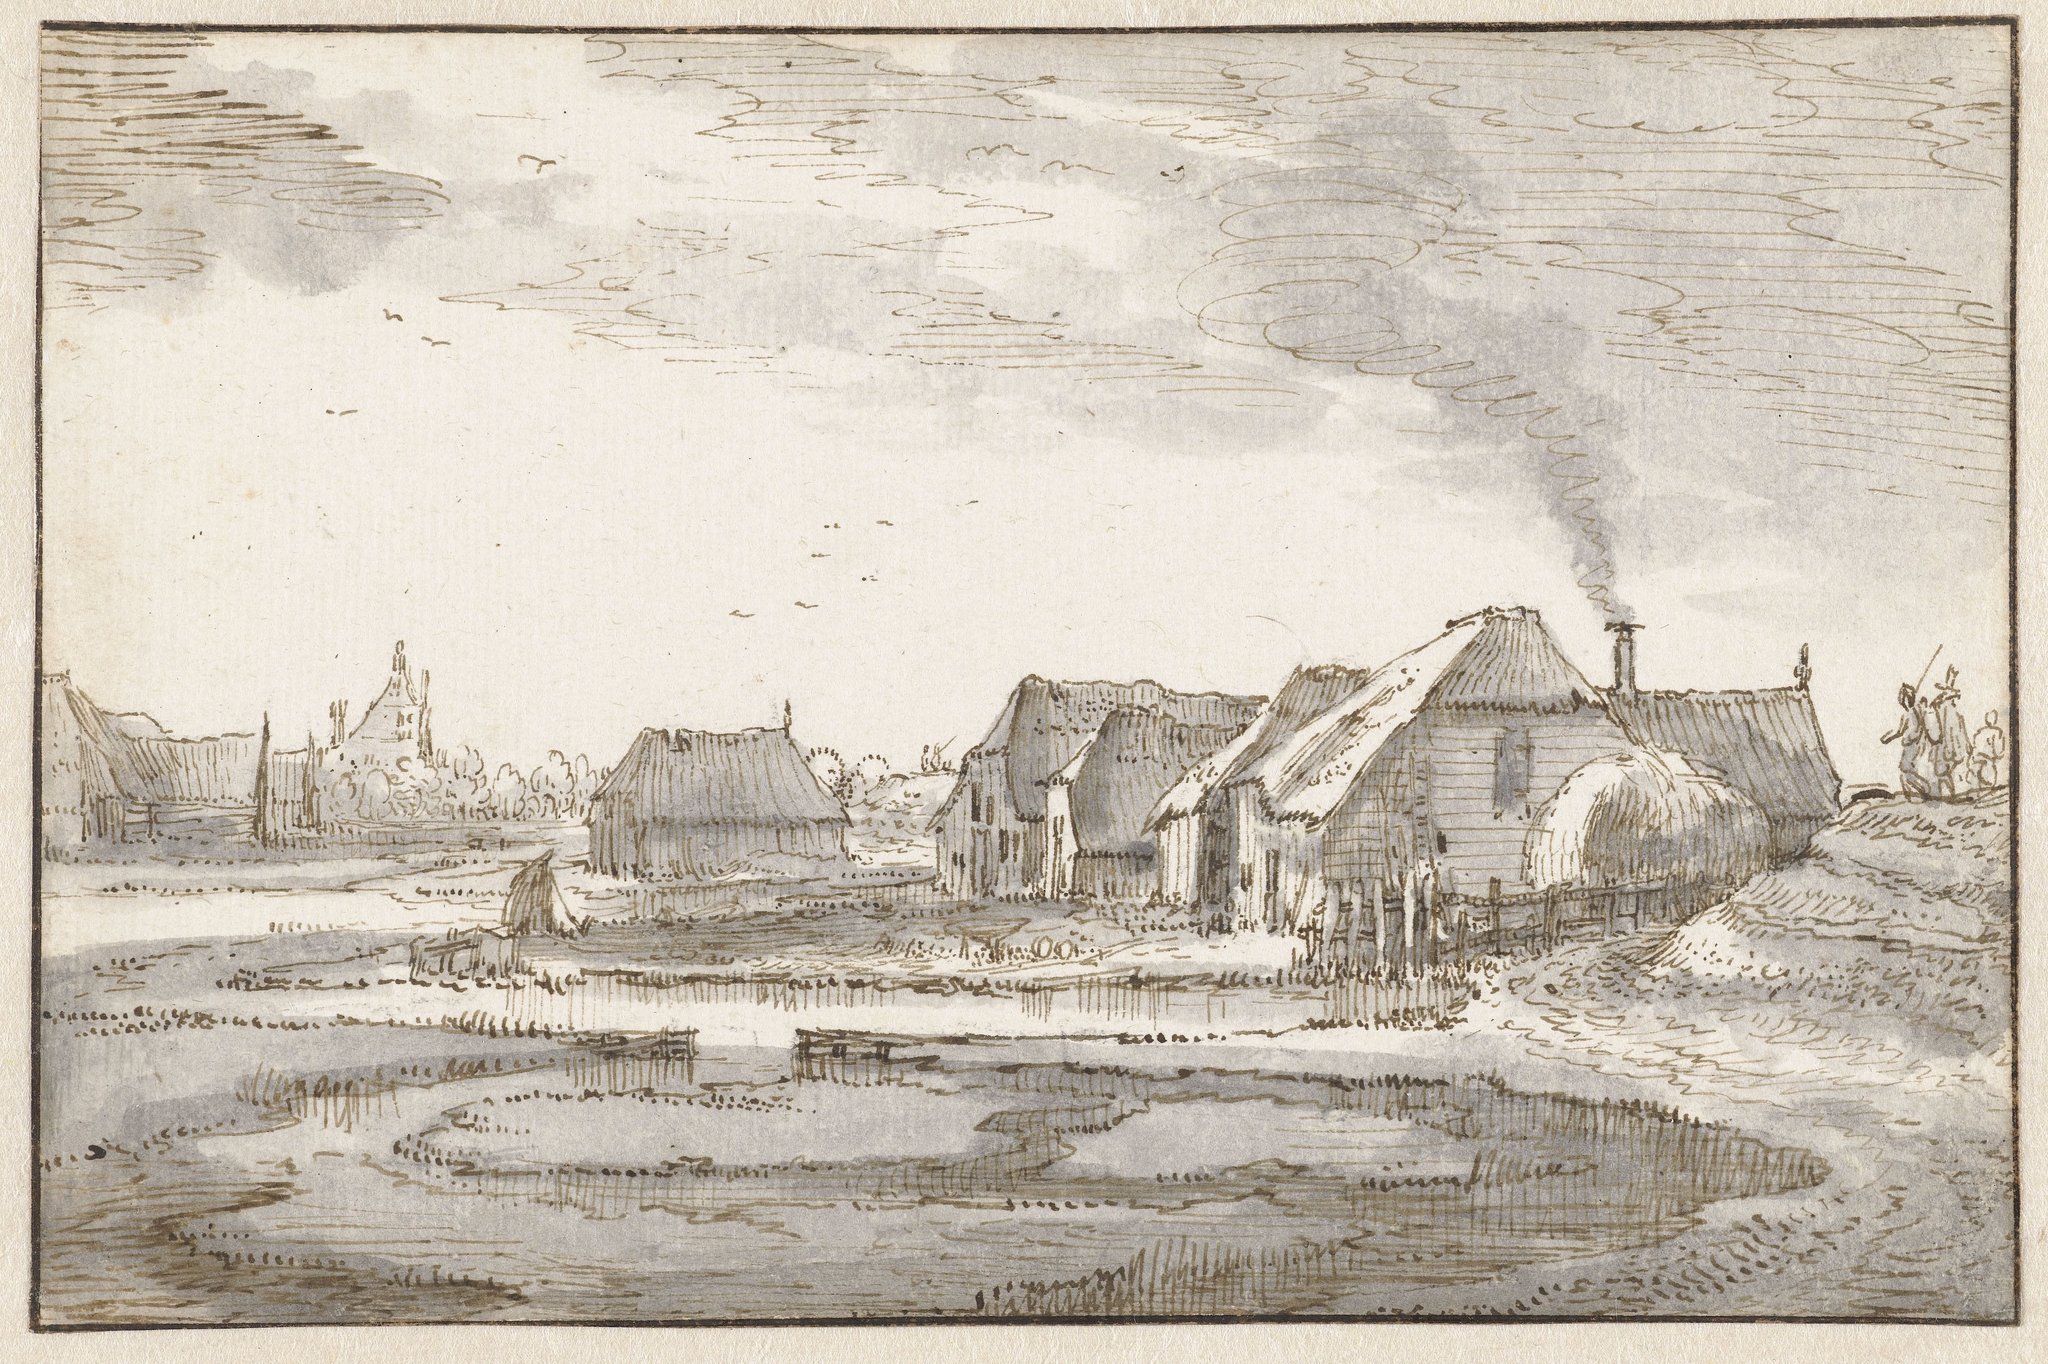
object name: drawing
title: Spaarndammerdijk bij de Braakjes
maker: claes jansz. visscher (ii)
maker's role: draughtsman, print maker, publisher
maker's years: 1586-1652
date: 1605-1615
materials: ink, paper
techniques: brush, pen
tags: farm or solitary house in landscape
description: Een paar schamele houten boerderijen aan een waterplas.